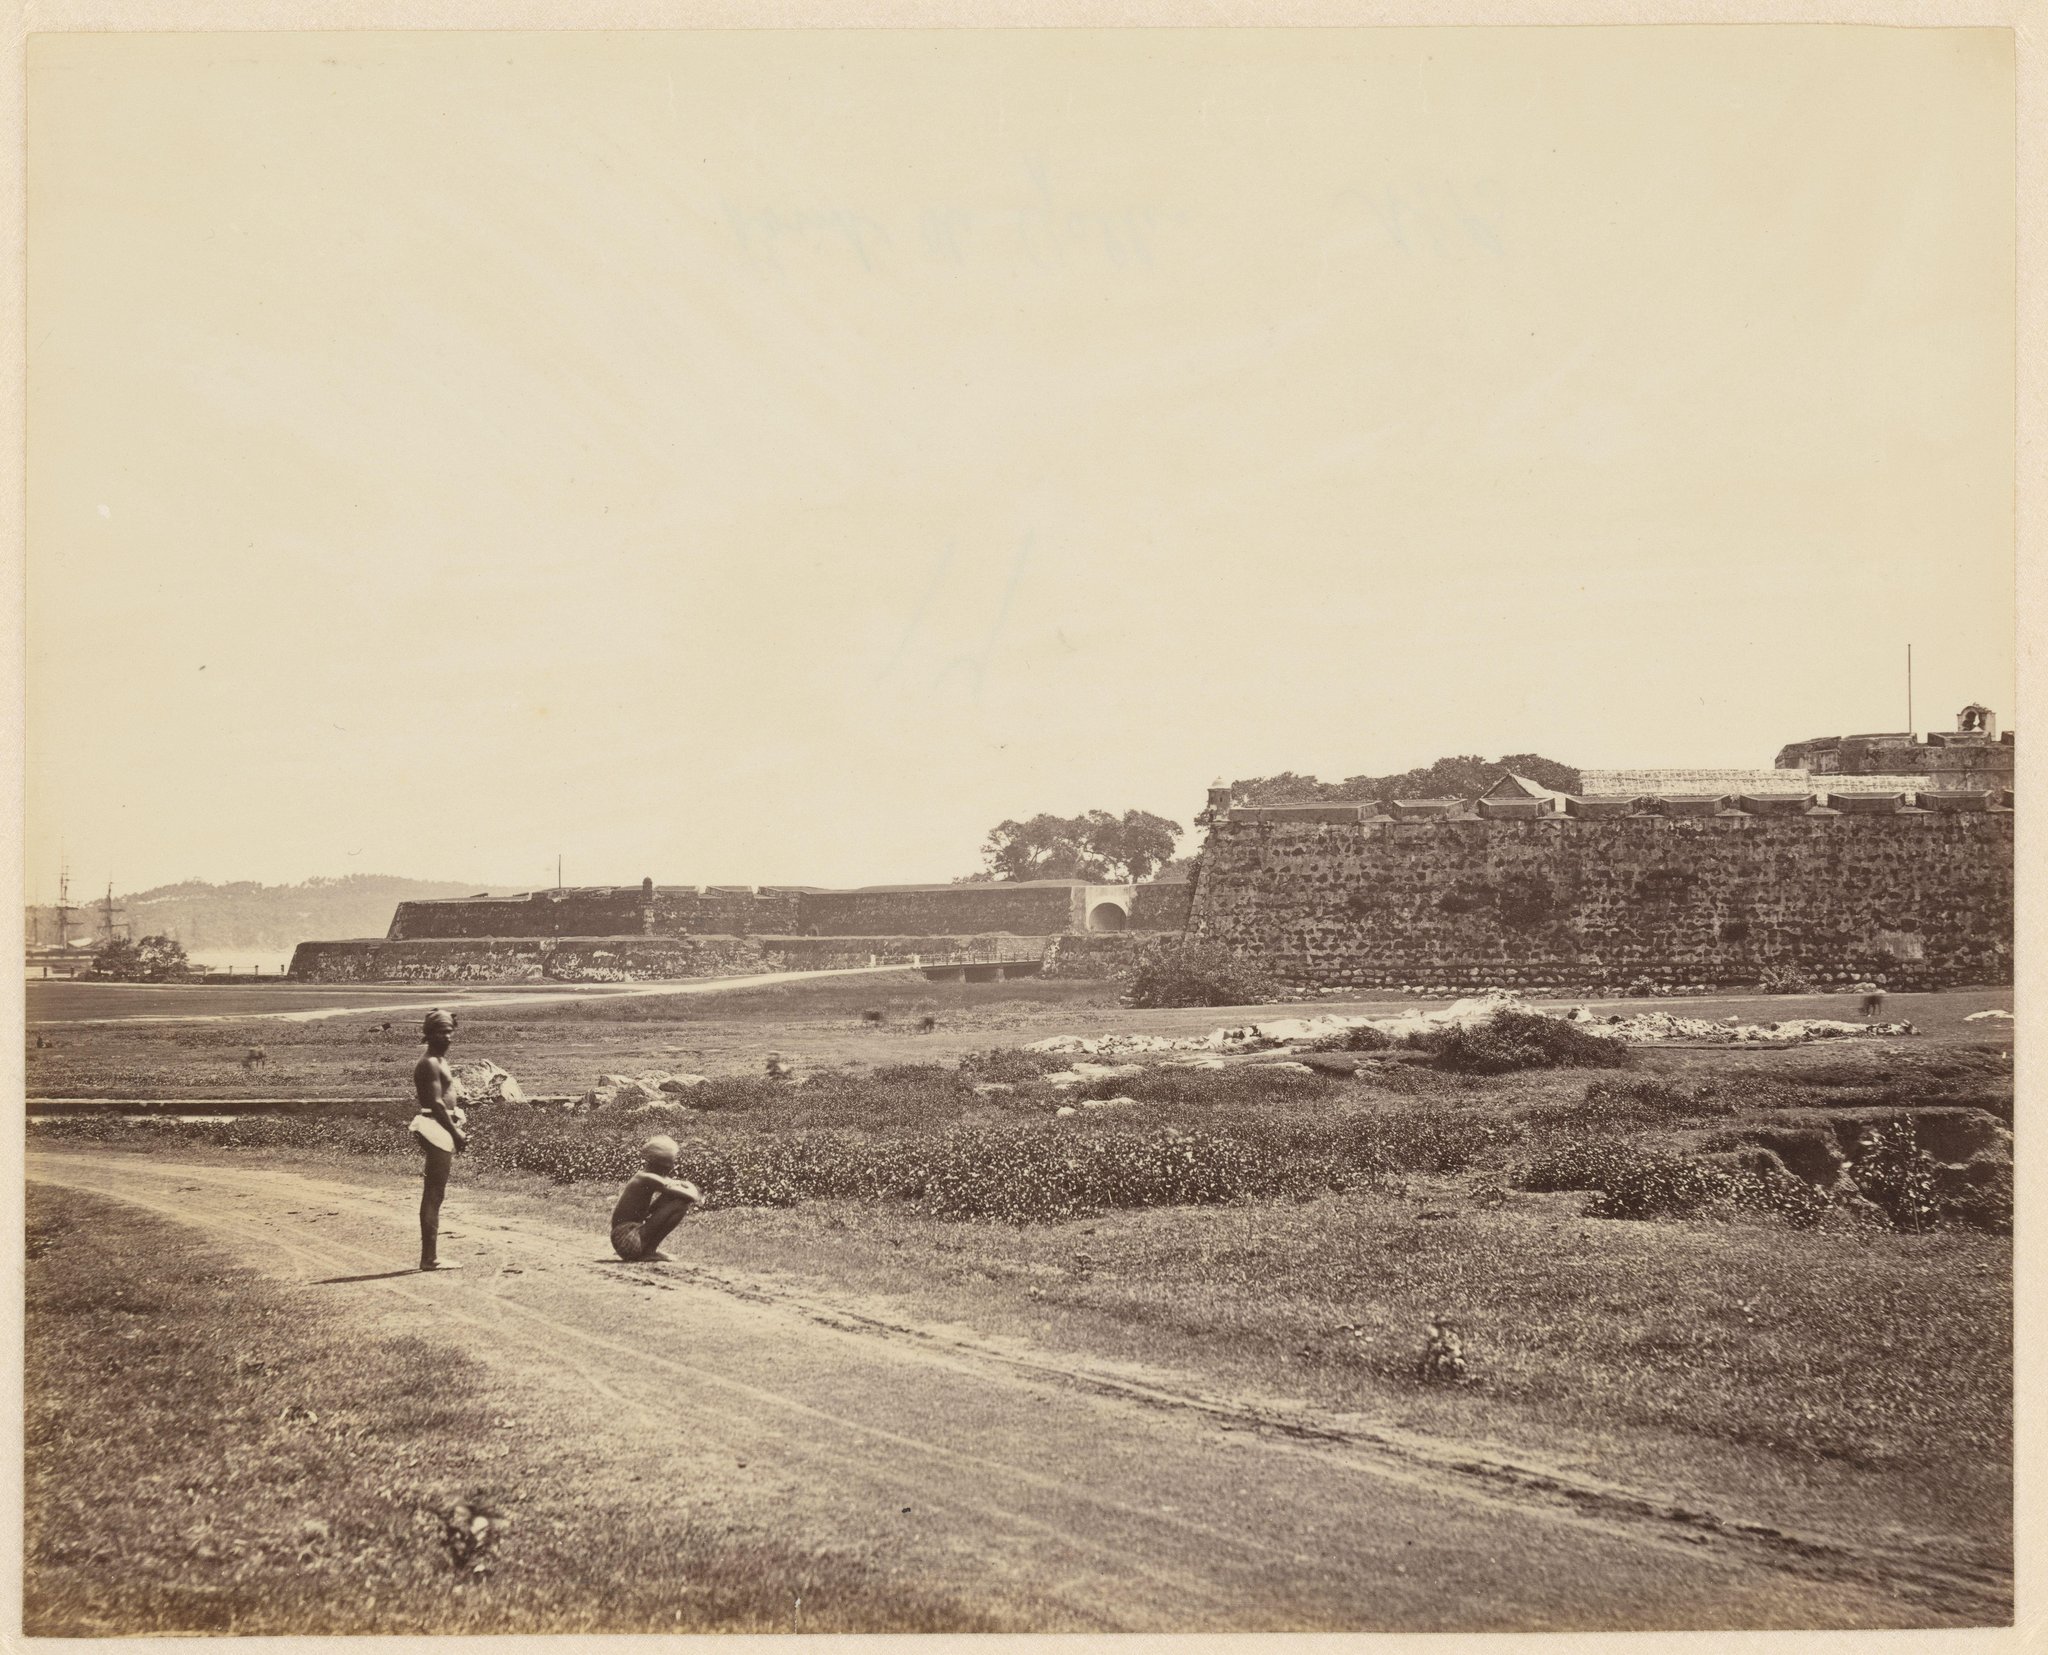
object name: photograph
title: Galle Fort in Sri Lanka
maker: Anonymous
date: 1865-1870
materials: paper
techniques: albumen print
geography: japan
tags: ceylon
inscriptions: number: ‘R14/9 [doorgestrepen]’, inscription: ‘A.[J].B.’, inscription: ‘Point de Galles’, number: ‘BD.126 [doorgestrepen]’, number: ‘14’, inscription: ‘The Fort Point de Galle’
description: In his final letter from Japan, Albert wrote that he hoped to return via India. The initials ‘A.J.B.’ on the back of this photo suggest Albert (Albertus Johannes) purchased it there. Galle Fort was captured by the Dutch from Portugal in 1640, around the same year they succeeded the Portuguese on Dejima as the only nation allowed to reside there. And to trade on the island, which was what really mattered.